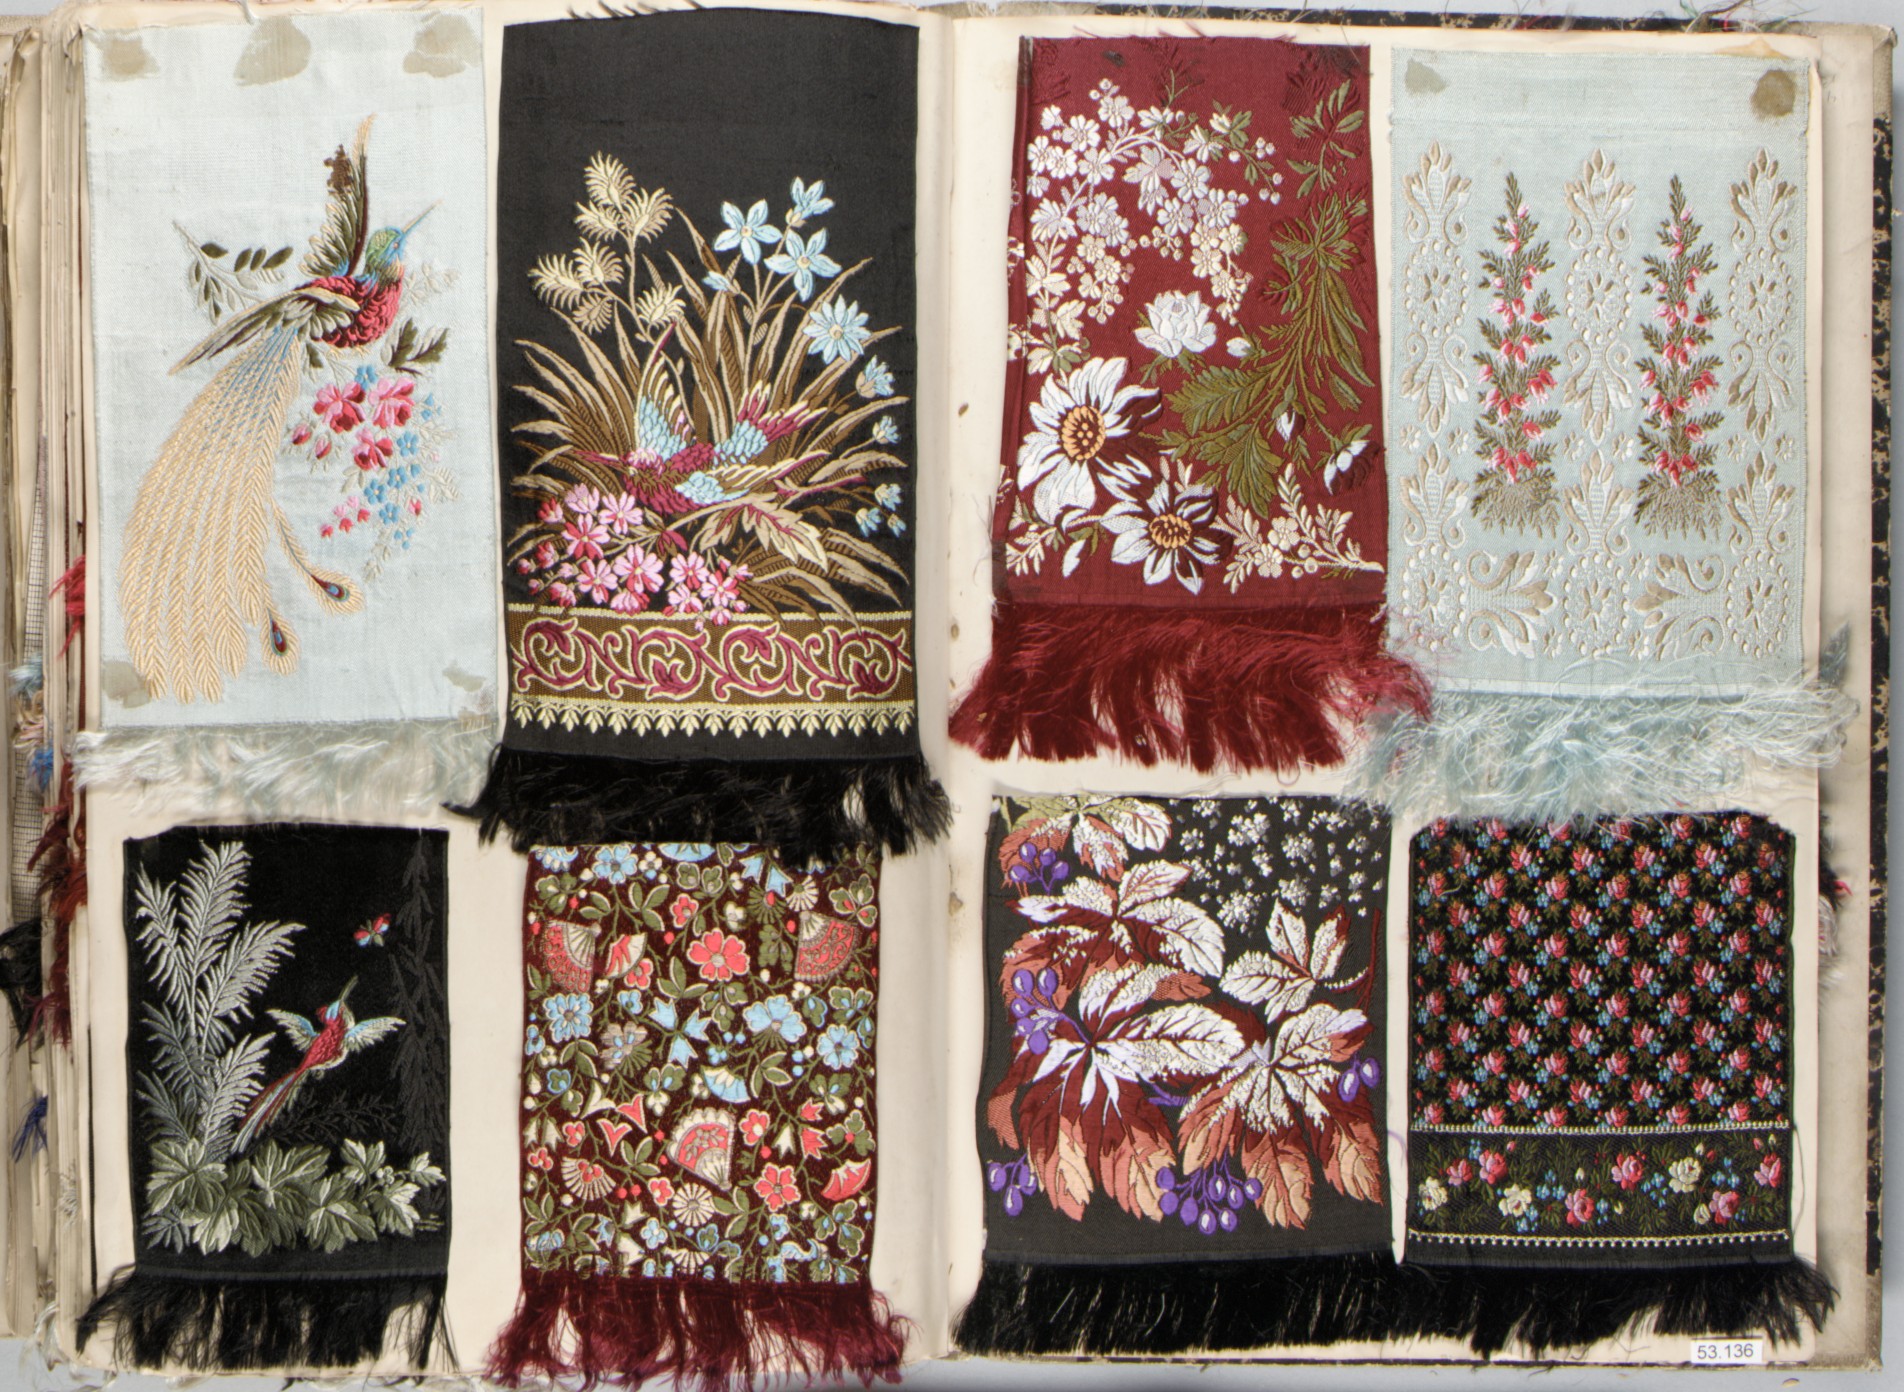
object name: album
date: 1878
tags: birds,insects,flowers,leaves